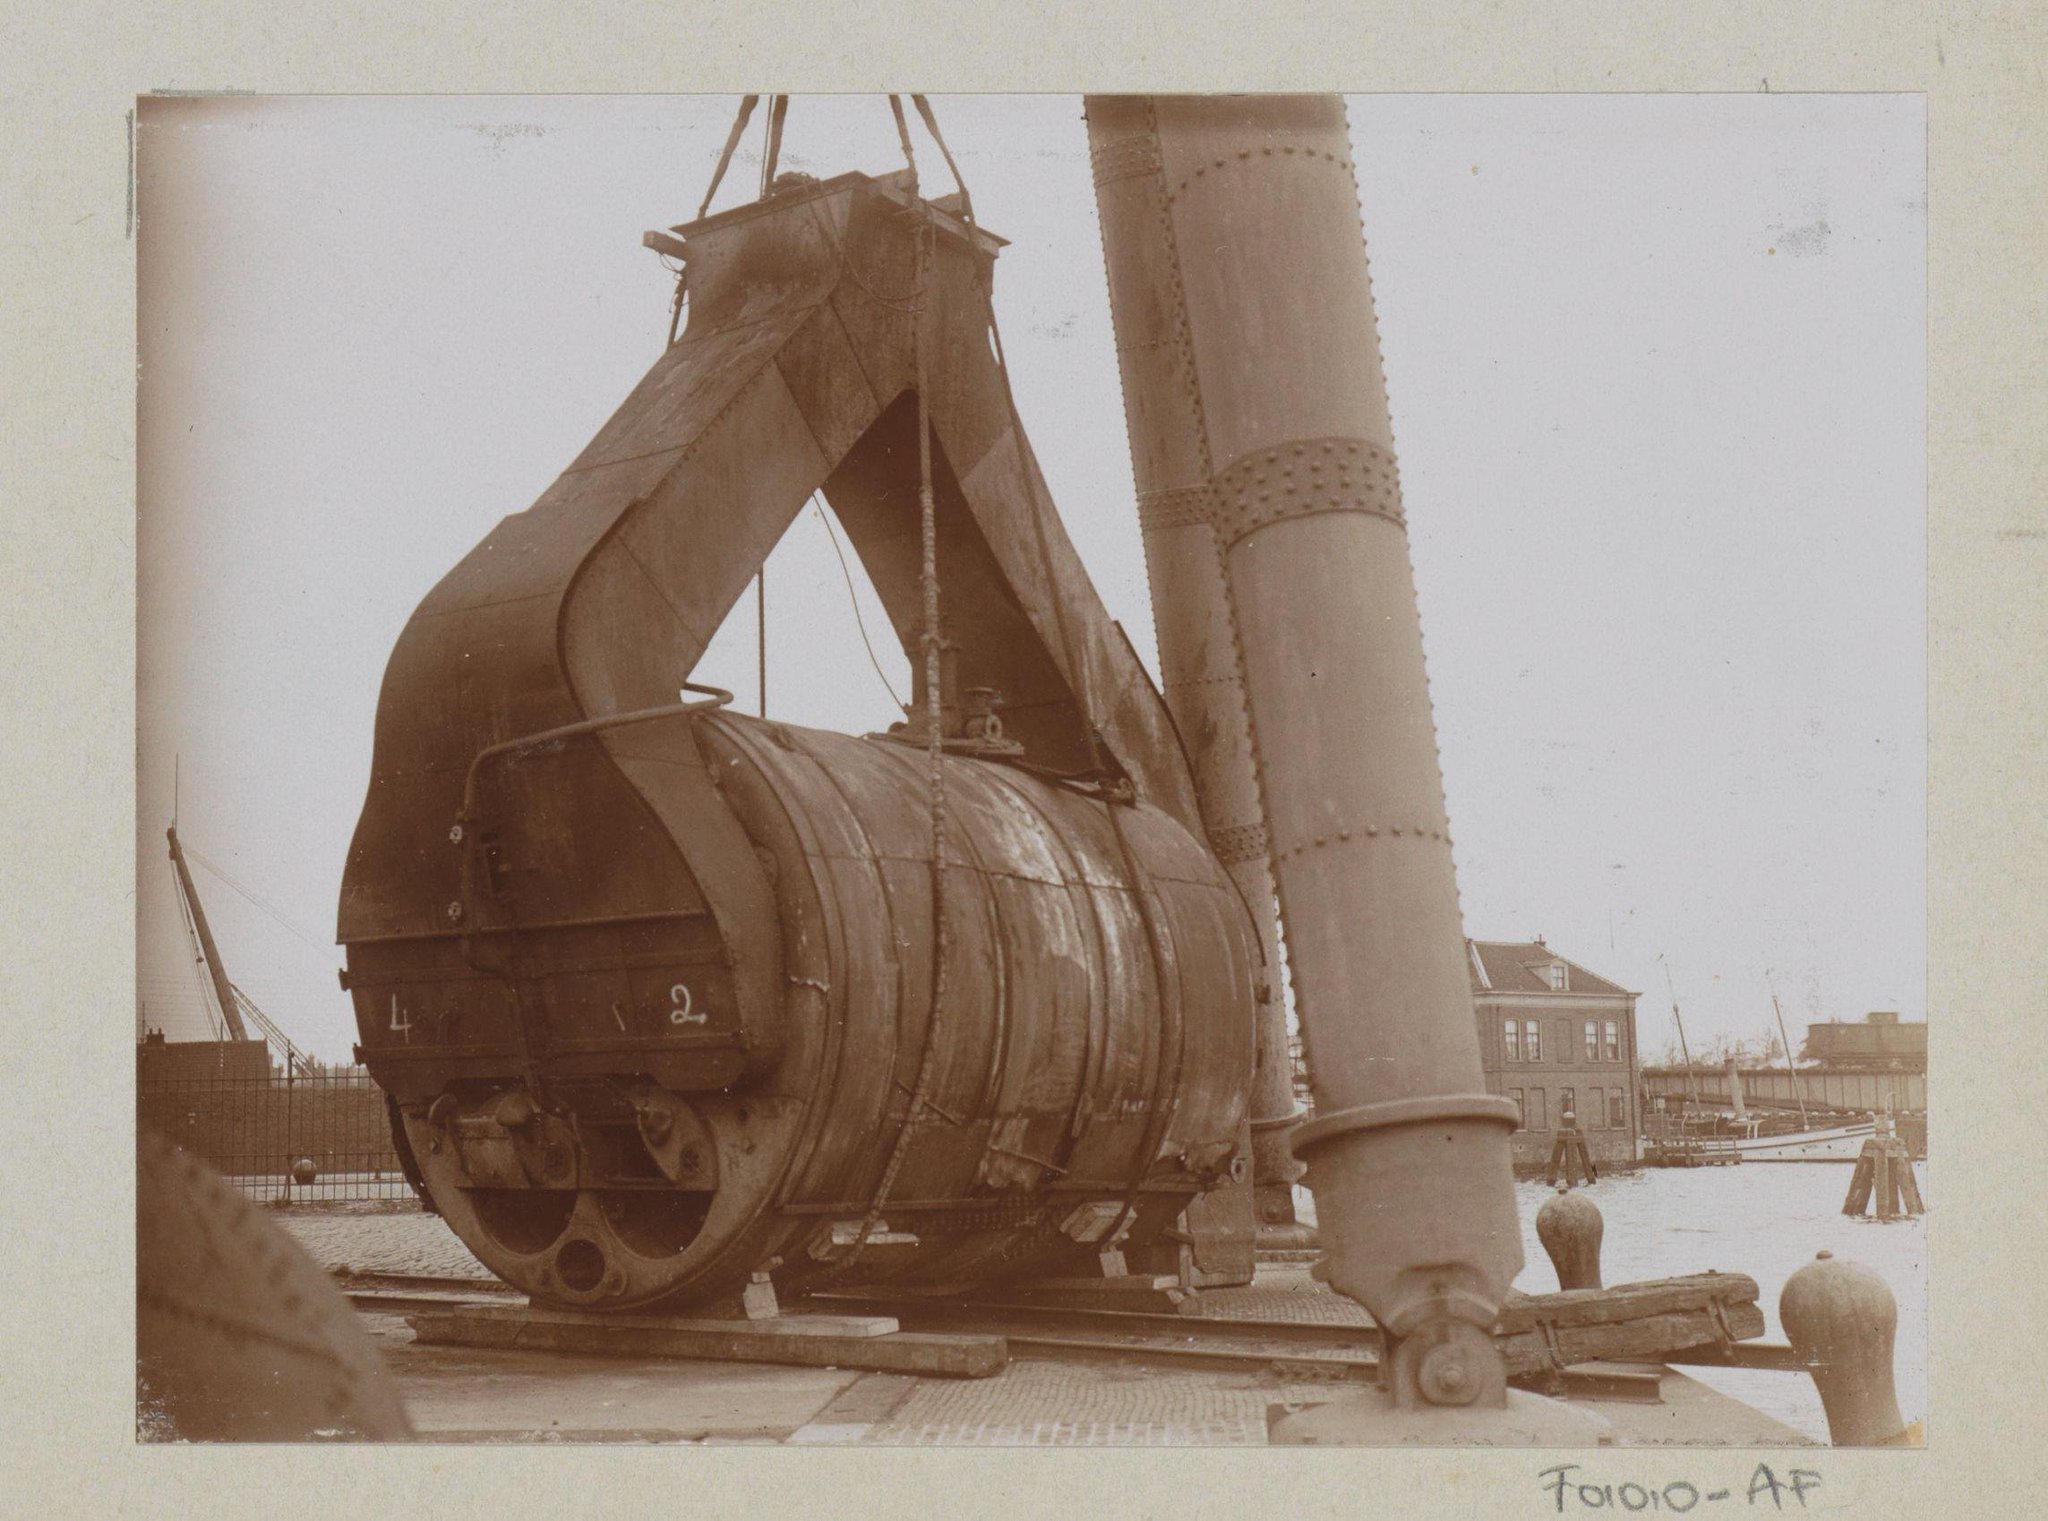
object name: photograph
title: Machinerie in de takels van een hijswerktuig aan een water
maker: Anonymous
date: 1900-1910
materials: photographic support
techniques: collodion silver print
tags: machines; parts of machines; tools and appliances, vertical transport, hoisting (industrial processes)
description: Onderdeel van Familiealbum met onder meer foto's van Wijnhandel Kraaij & Co. Bordeaux-Amsterdam.